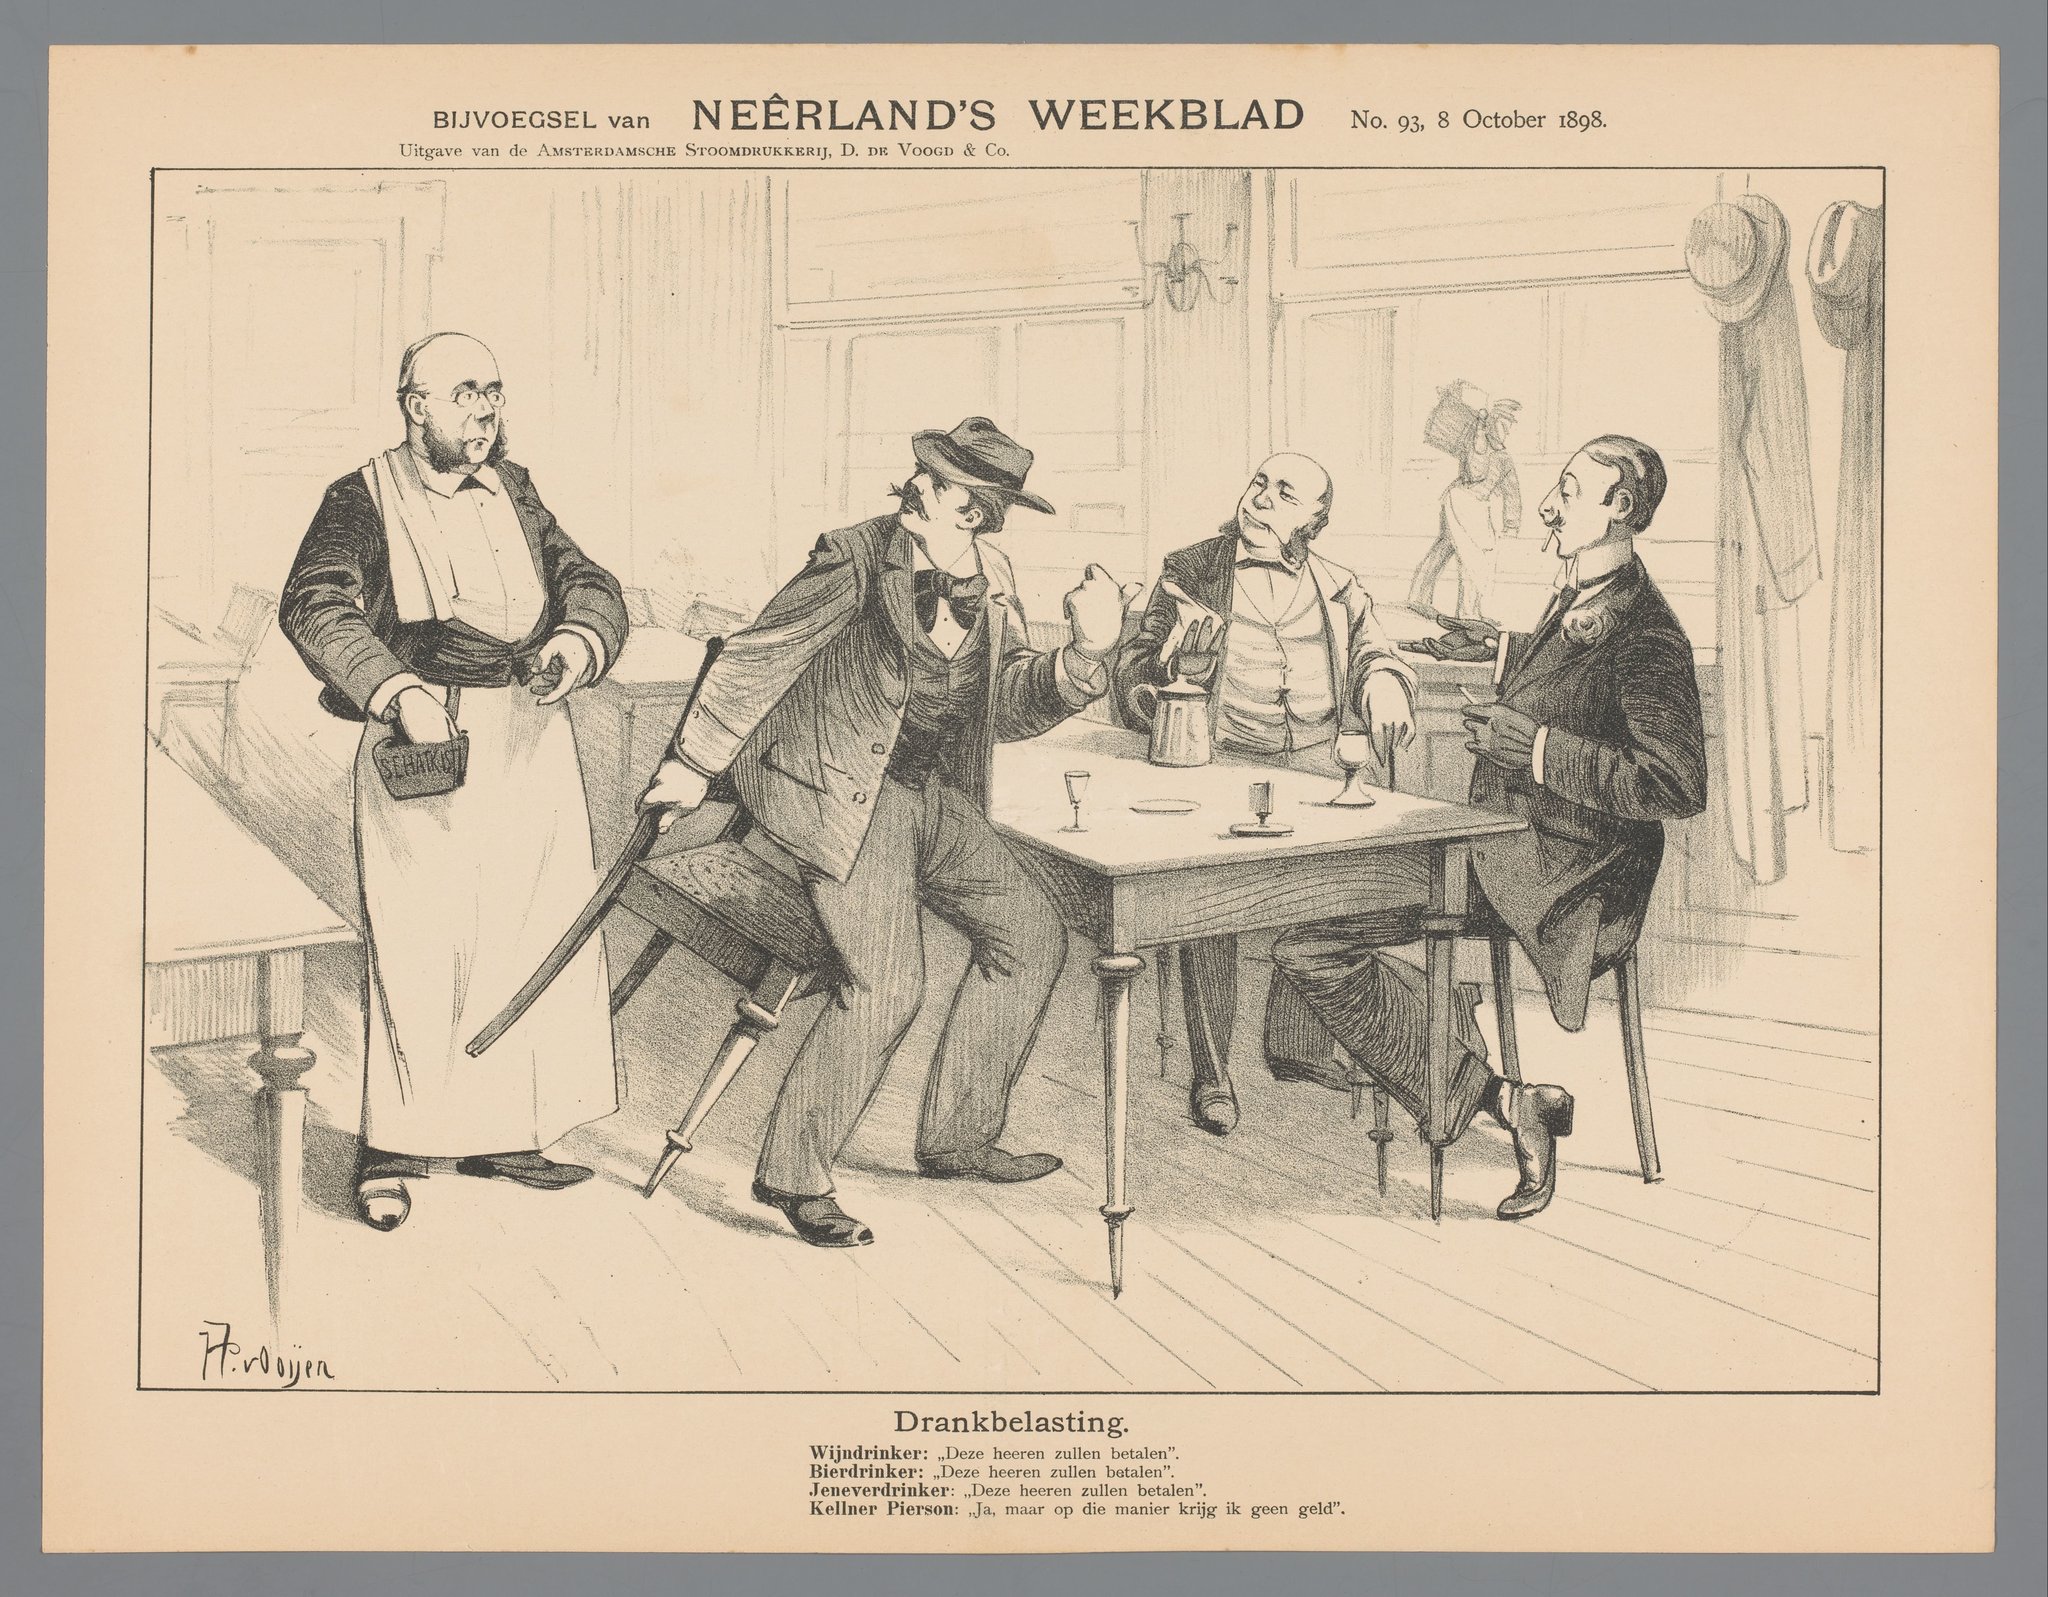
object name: cartoon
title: Drankbelasting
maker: h. van ooijen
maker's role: print maker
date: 1898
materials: paper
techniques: lithograph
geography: amsterdam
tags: amsterdam, politician, nicolaas gerard pierson, historical persons, alcoholic drinks, political caricatures and satires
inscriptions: date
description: Prent uit het bijvoegsel van: Neêrland’s Weekblad, nr. 93, 8 oktober 1898.